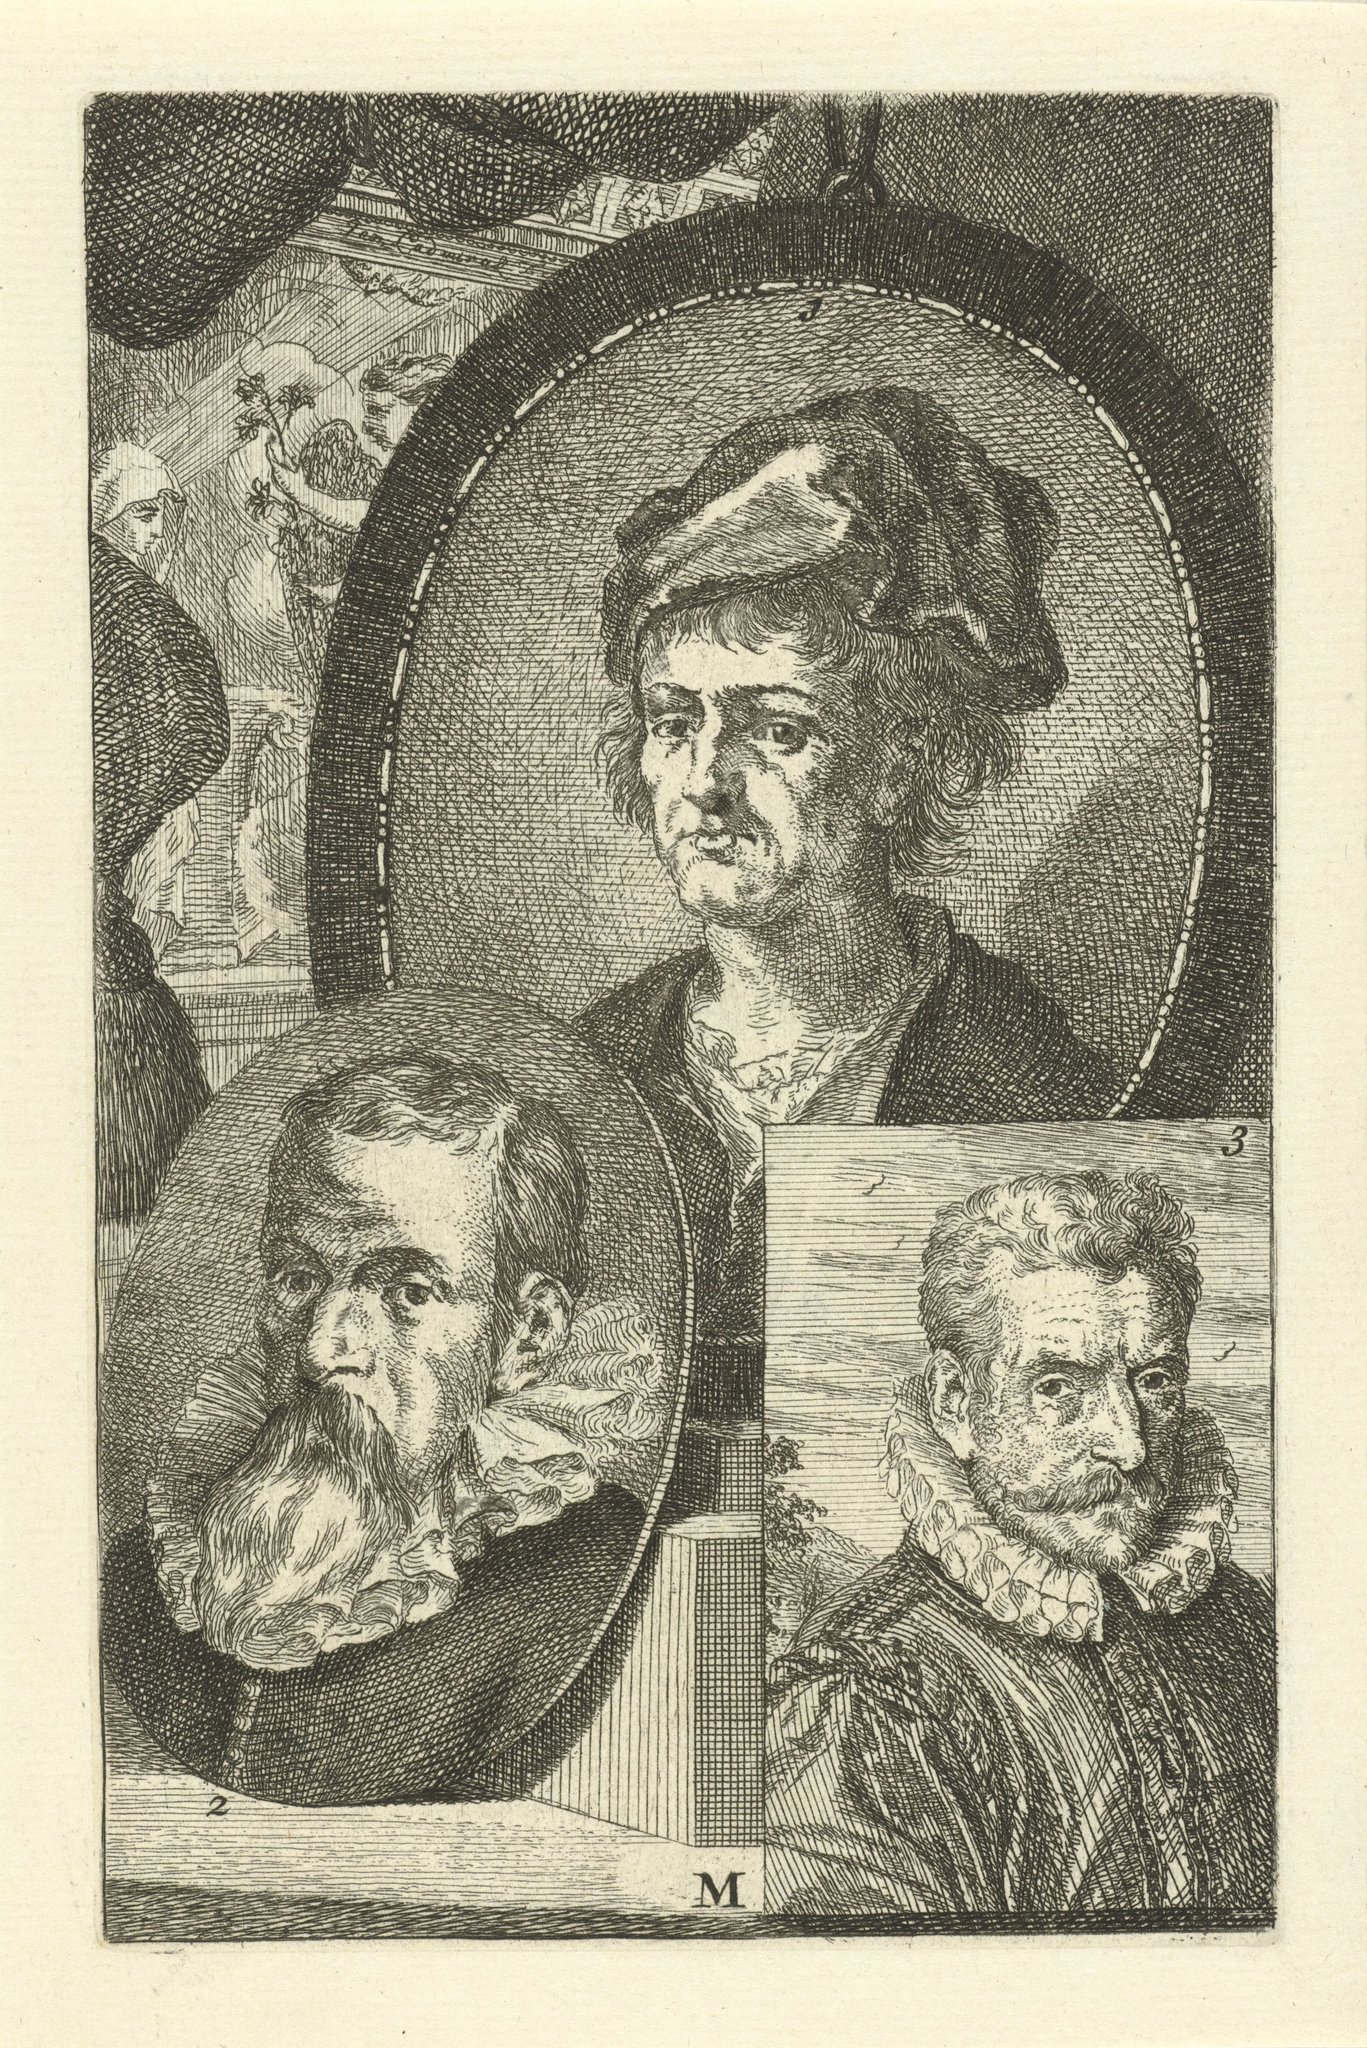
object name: book illustration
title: Portretten van Jan Joest van Calcar, Christoffel Zwarts en Philips Galle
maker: jan l admiral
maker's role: draughtsman, print maker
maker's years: 1699-1773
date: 1764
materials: paper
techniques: etching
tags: haarlem, antwerp, print maker, publisher, philips galle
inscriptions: collector's mark: Lugt 2228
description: Prent opgenomen in: Mander, Karel van; Jongh, Jacobus de (vert.). Het leven der doorluchtige Nederlandsche en eenige Hoogduitsche schilders. Amsterdam: Steven van Esveldt, 1764.